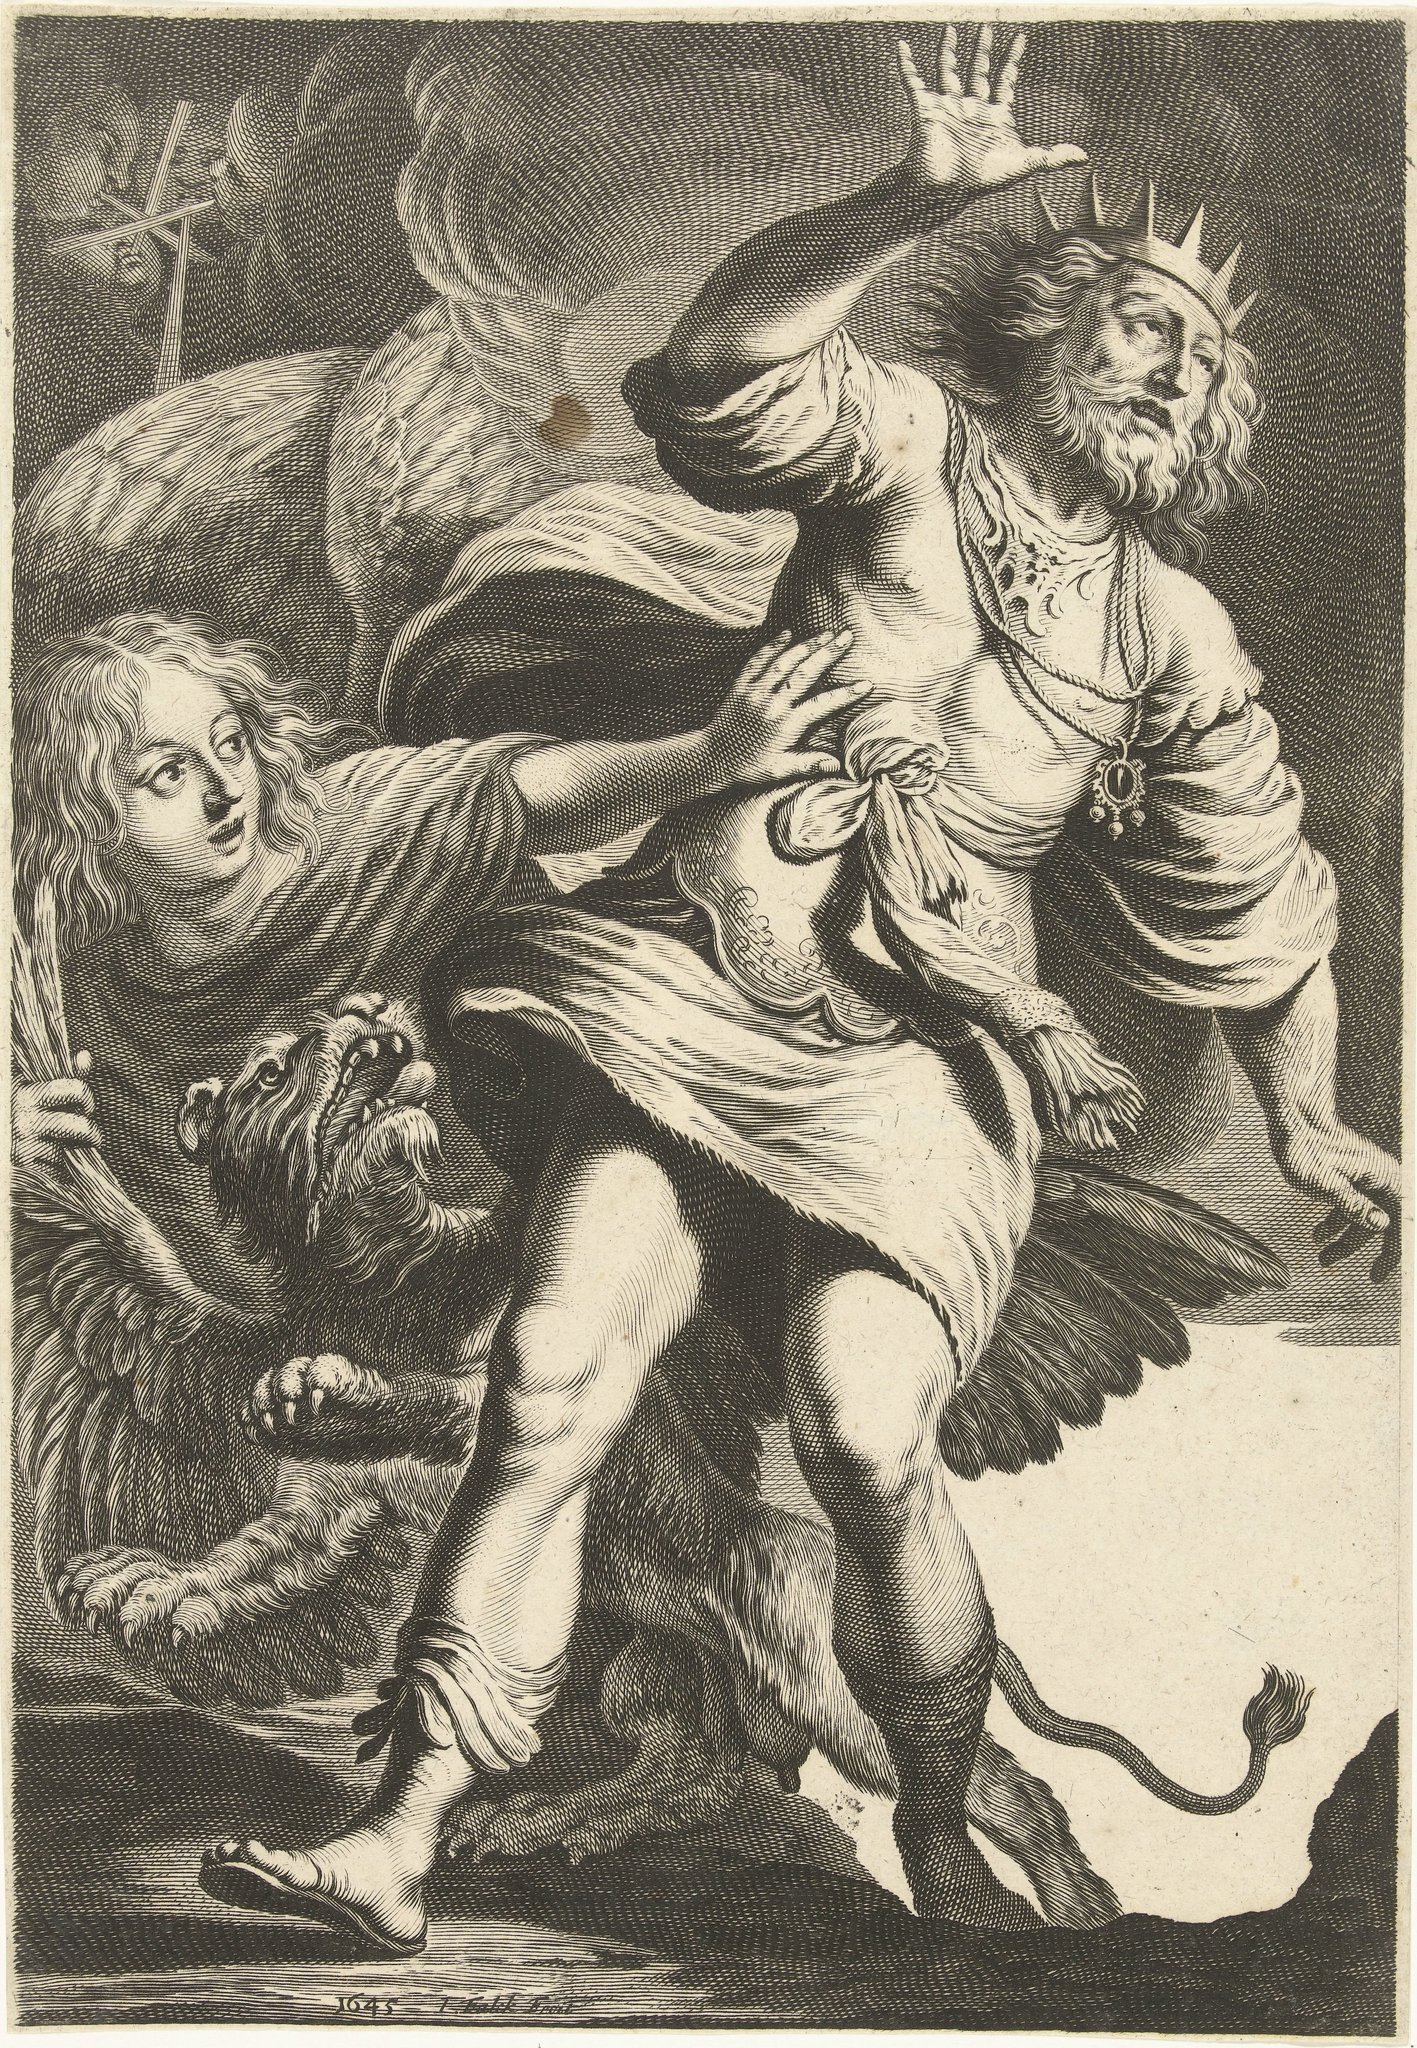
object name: print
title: De vier koninkrijken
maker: jeremias falck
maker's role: print maker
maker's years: 1609-1677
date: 1645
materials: paper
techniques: engraving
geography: paris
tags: destroying angel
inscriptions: collector's mark: Lugt 2228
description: Koning Sanherib van Assyrië wordt omver geduwd door een engel die de vleugel van een gevleugelde leeuw vasthoudt. Linksboven blazen de vier windrichtingen. Kopie in spiegelbeeld naar prent met dezelfde titel.